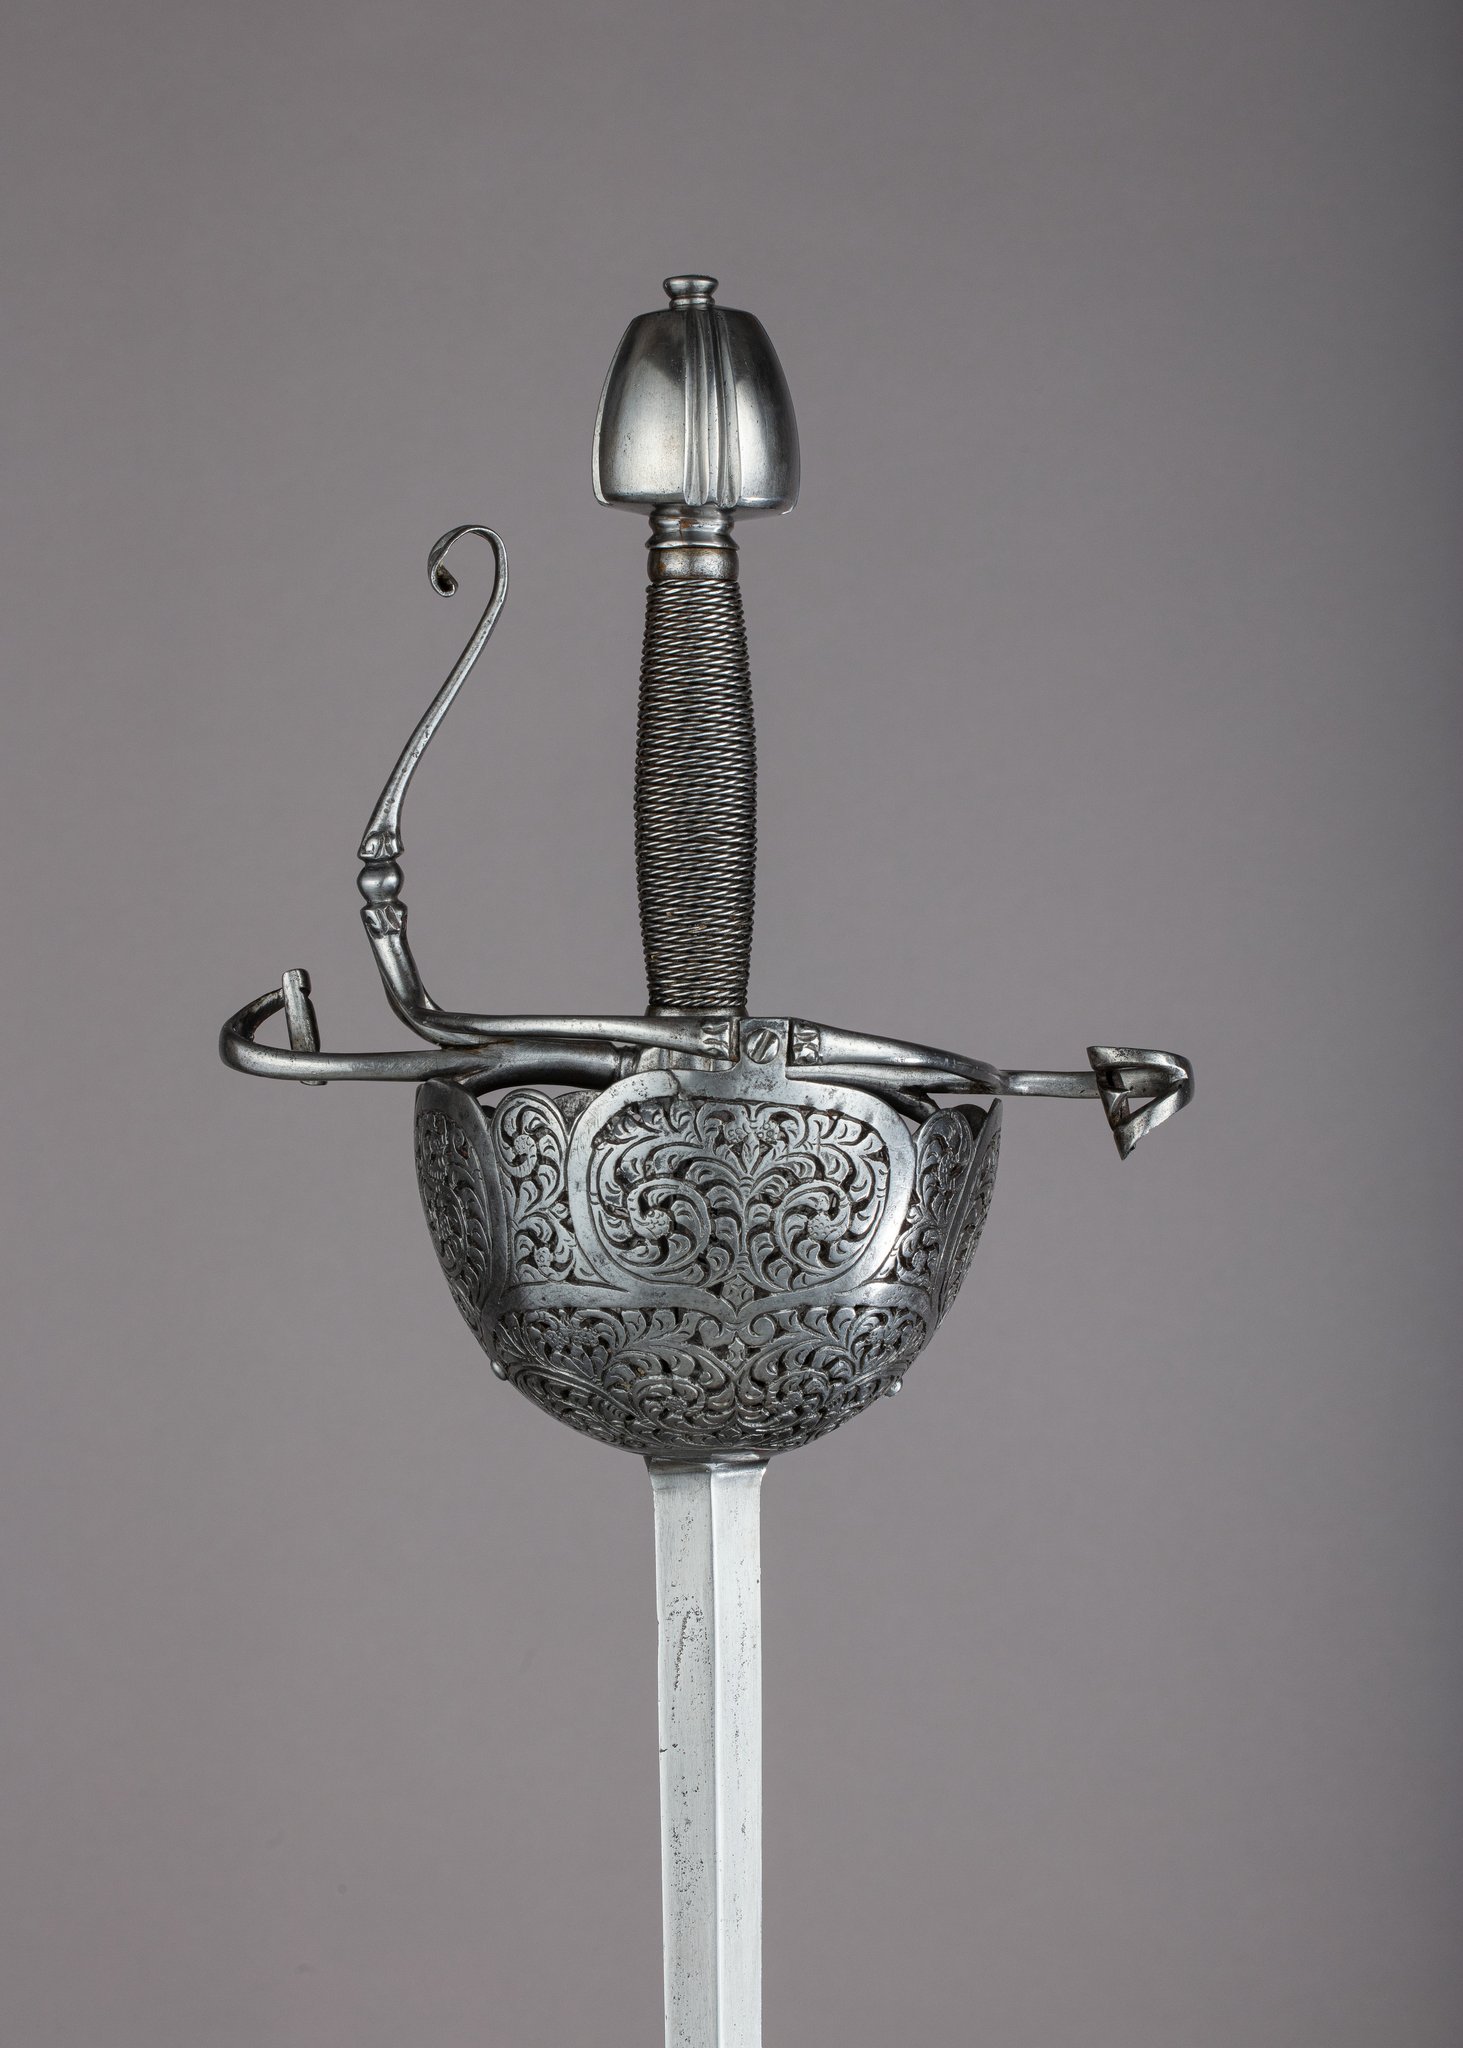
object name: cup hilted rapier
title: Cup-Hilted Rapier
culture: spanish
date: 1601-1633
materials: steel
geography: spain